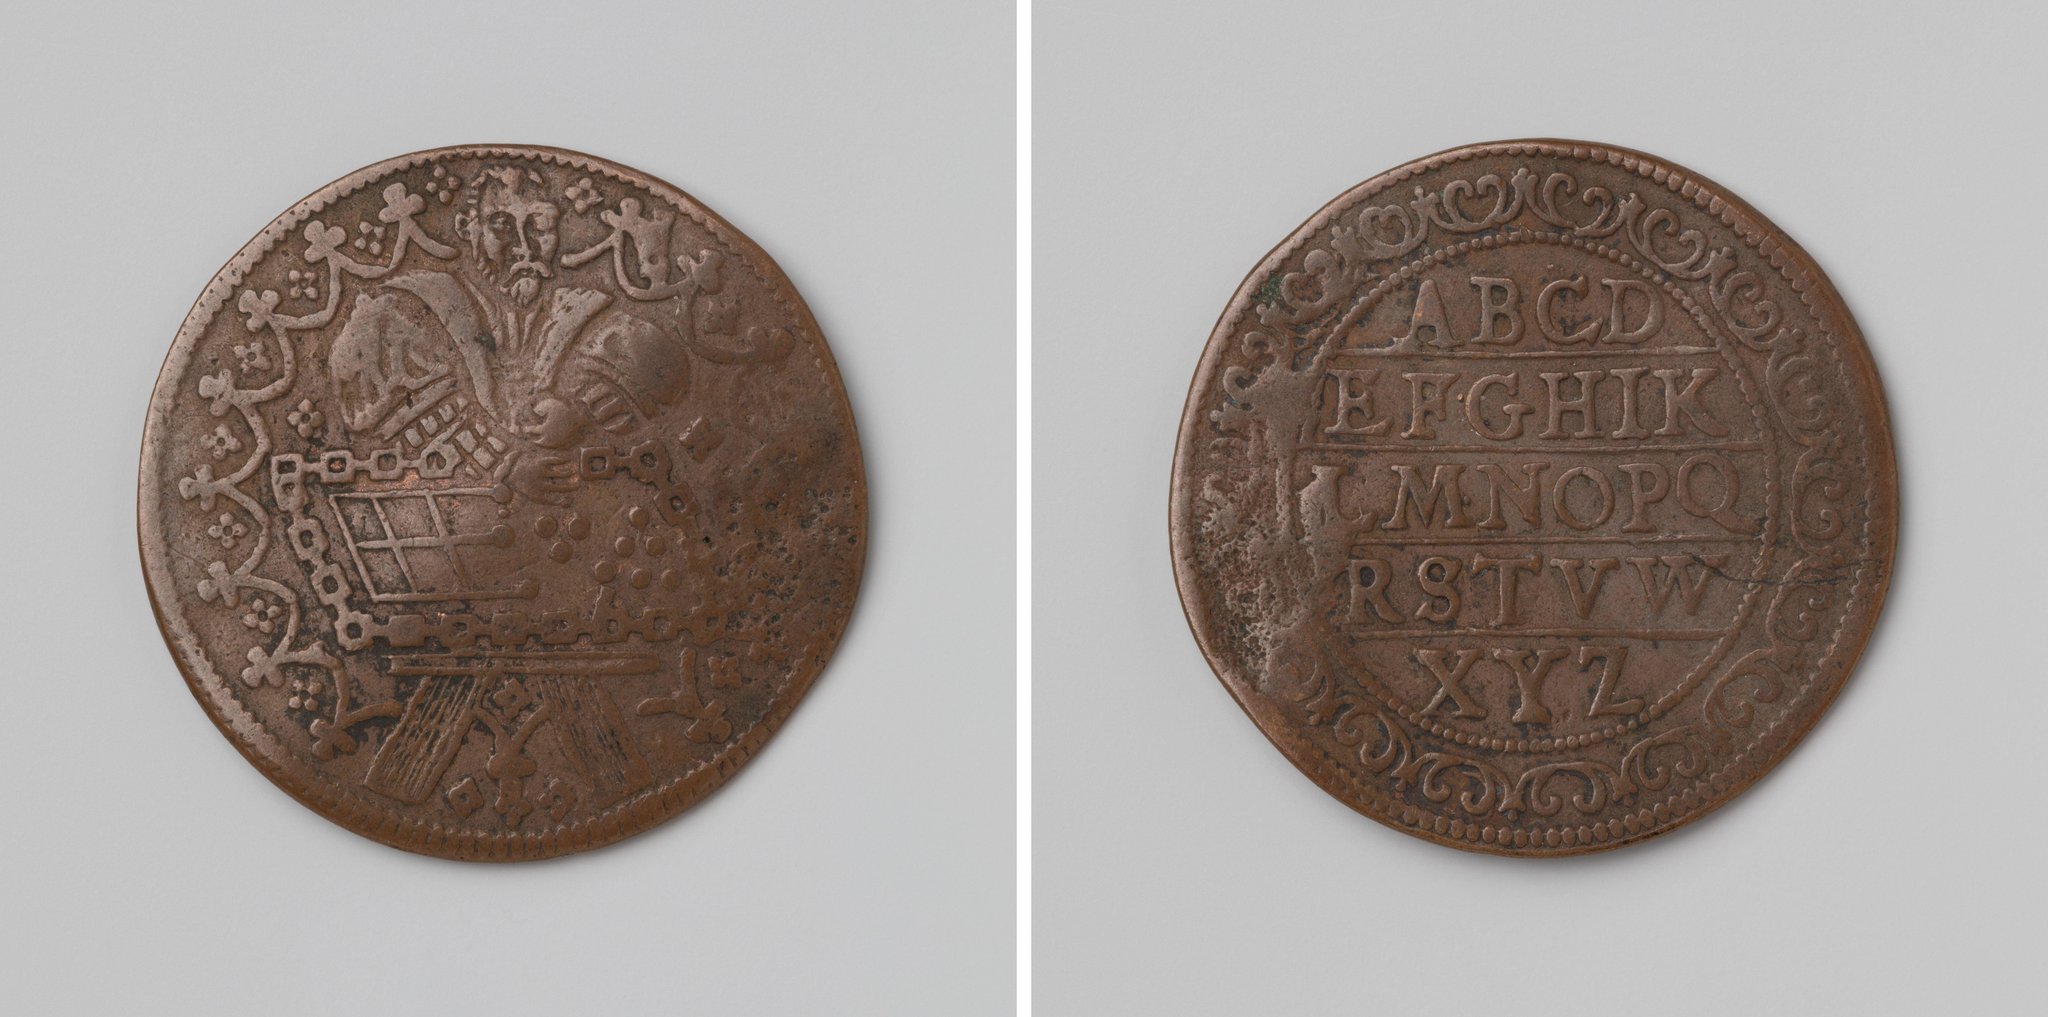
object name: jeton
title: Schoolpenning: rekenpenning waarop het werken met rekenpenningen en het alfabet wordt getoond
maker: Anonymous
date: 1525-1575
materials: copper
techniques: striking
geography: netherlands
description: Koperen penning. Voorzijde: man staande achter tafel, waarop lijnen zijn getrokken en penningen liggen binnen sierrand. Keerzijde: alfabet in vijf boven elkaar geplaatste regels binnen sierrand.